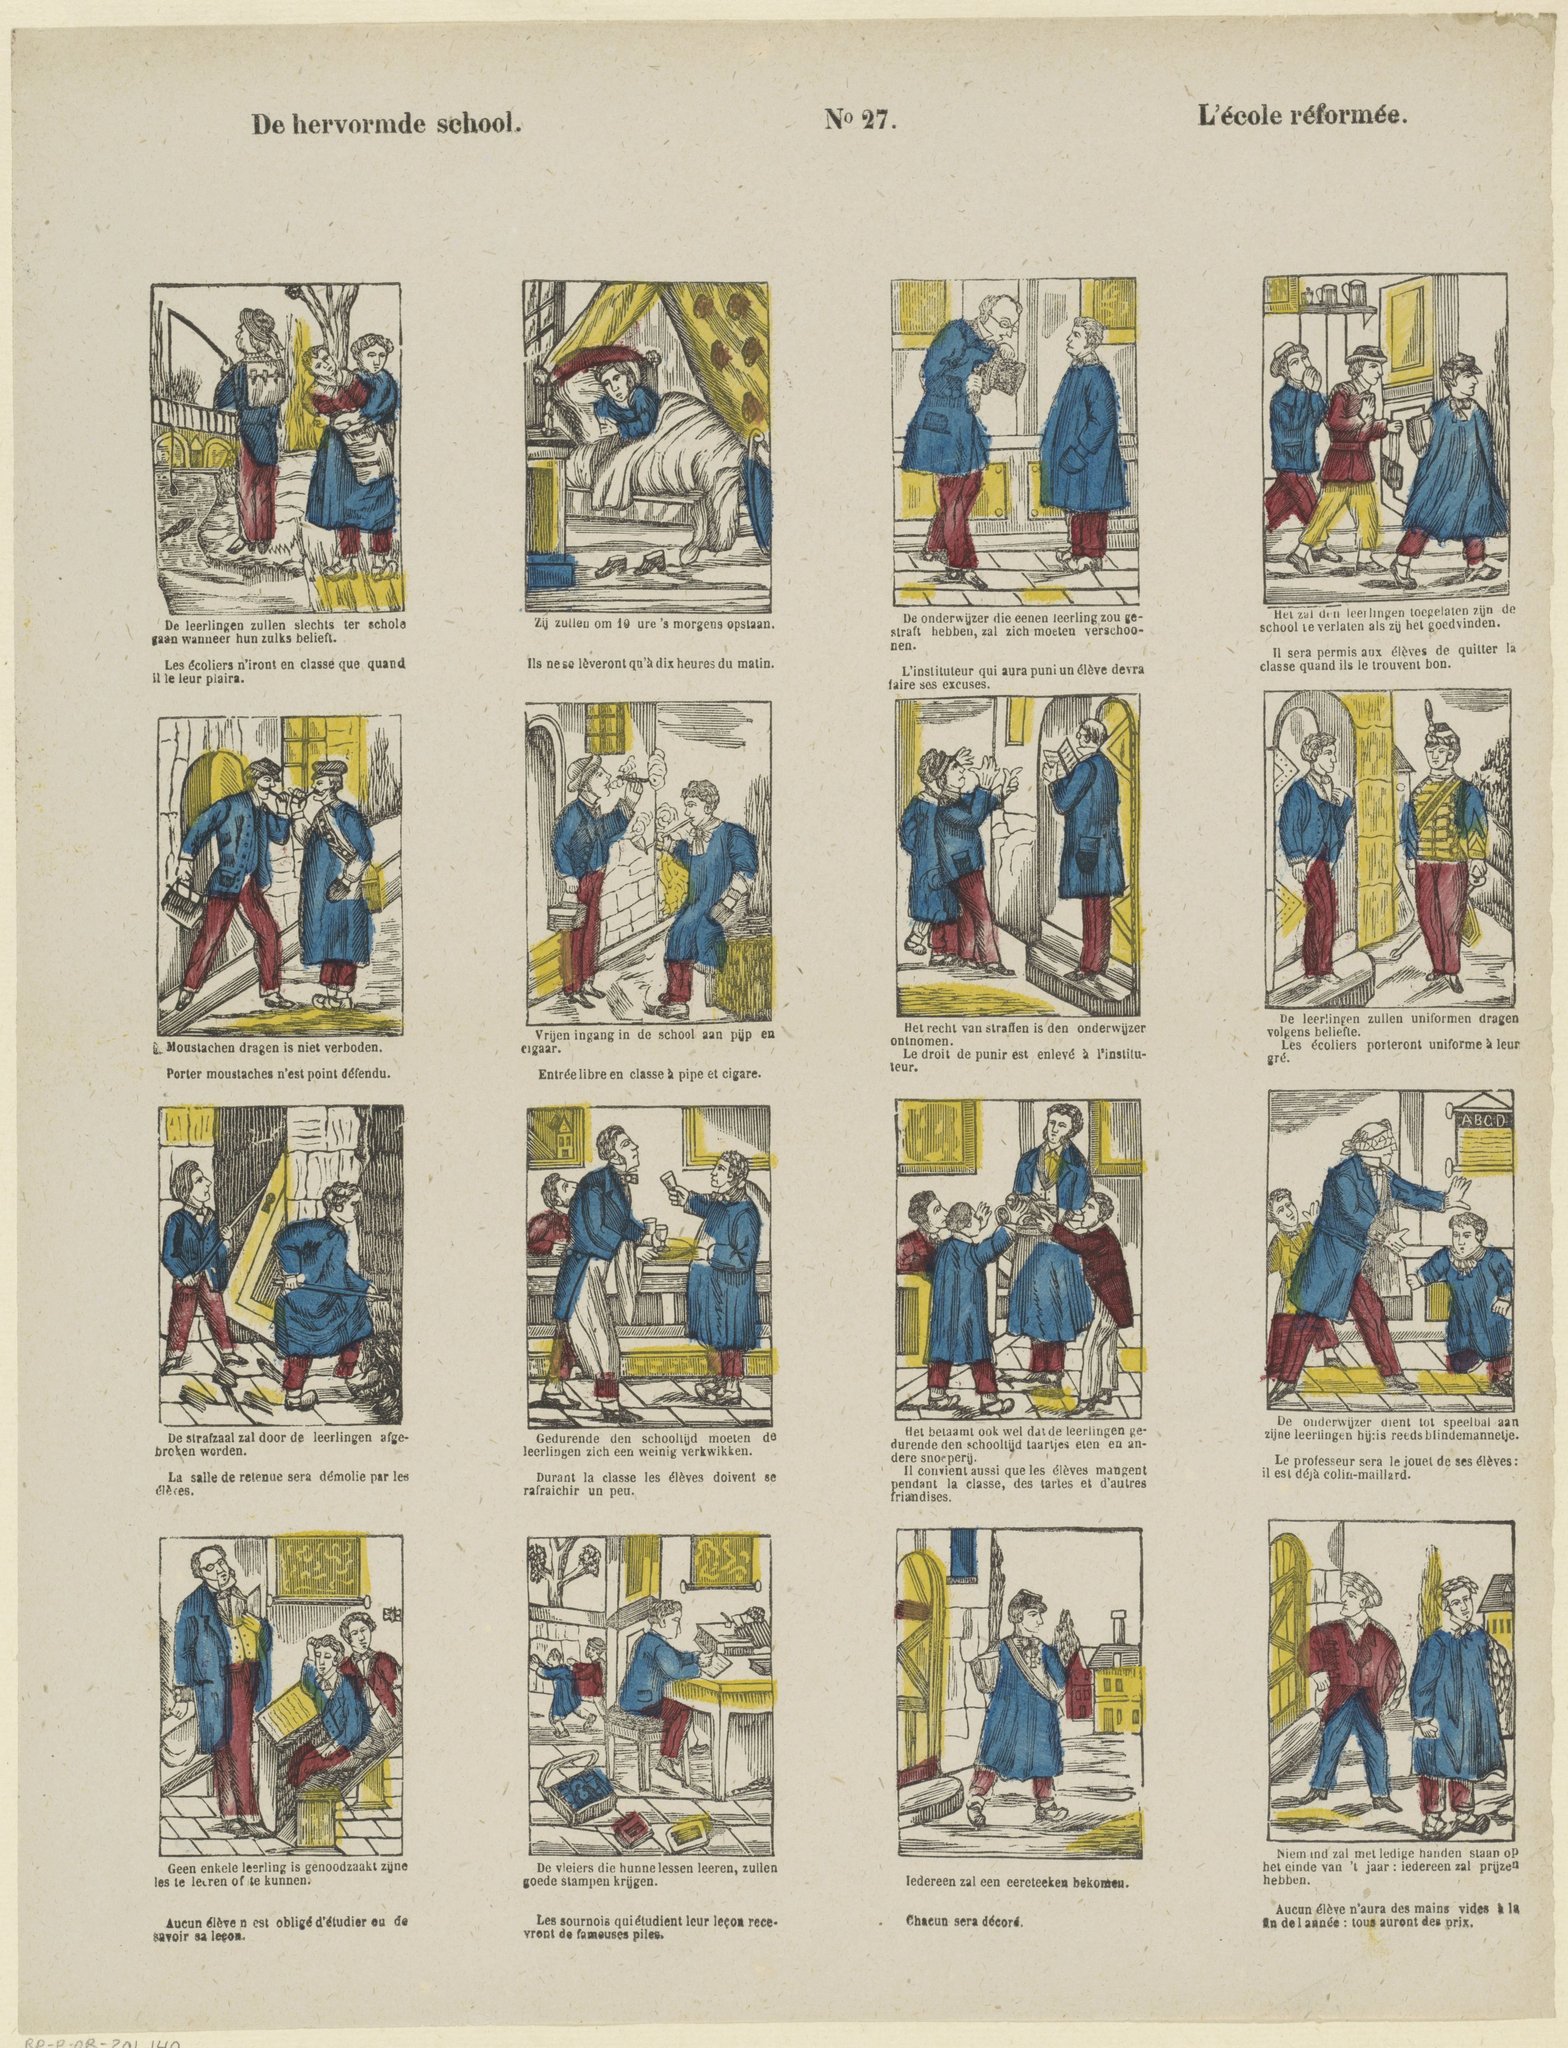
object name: popular print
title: De hervormde school / L'école réformée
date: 1866-1902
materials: paper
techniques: colour, letterpress printing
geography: europe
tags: games at school, teacher and pupil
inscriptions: collector's mark: Lugt 2760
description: Blad met 16 voorstellingen van leraren en leerlingen op een hervormde school. Onder elke afbeelding een onderschrift in het Nederlands en in het Frans. Genummerd midden boven: No 27.